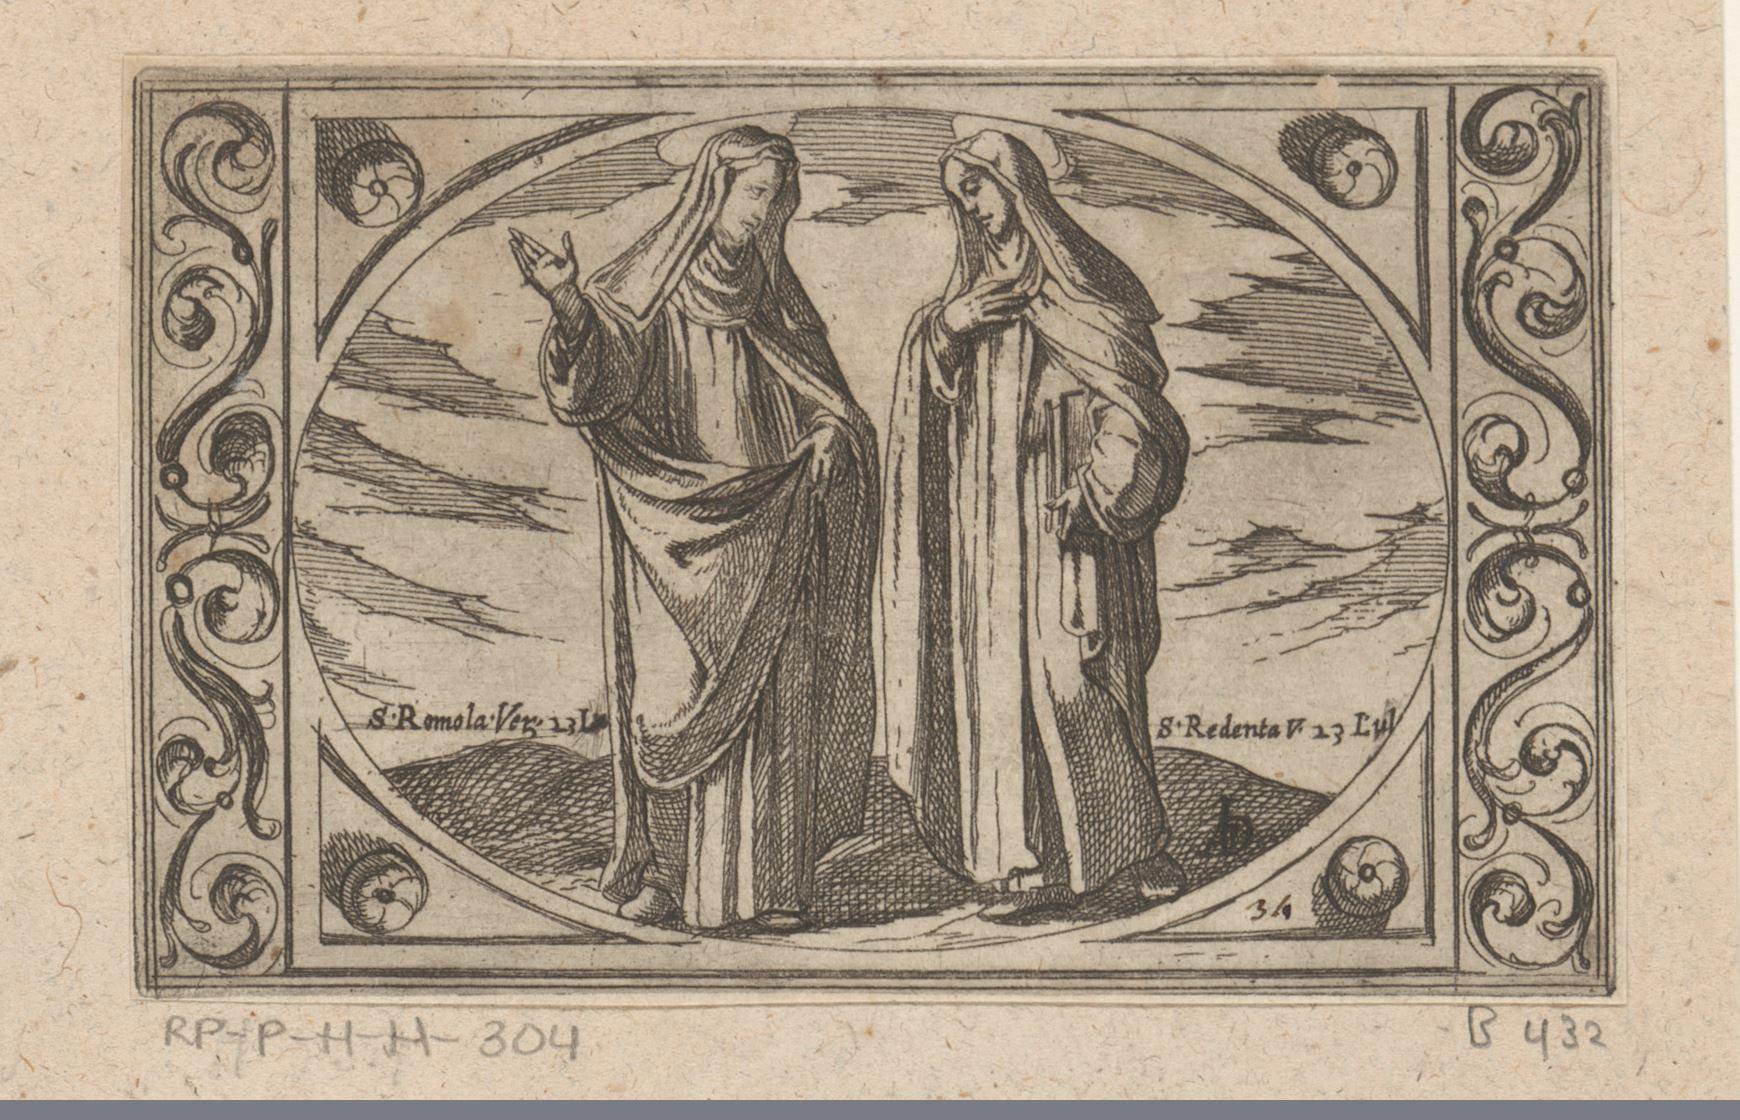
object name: print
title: Imagini di moltes vergini Rom nel martirio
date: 1565-1630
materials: paper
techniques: etching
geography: rome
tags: martyr(s) (often with palm-branches) - qq - female martyr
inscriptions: number: ‘34’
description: Deze prent maakt deel uit van een reeks van 73 prenten (+ titelprent) met voorstellingen van Romeinse martelaressen.